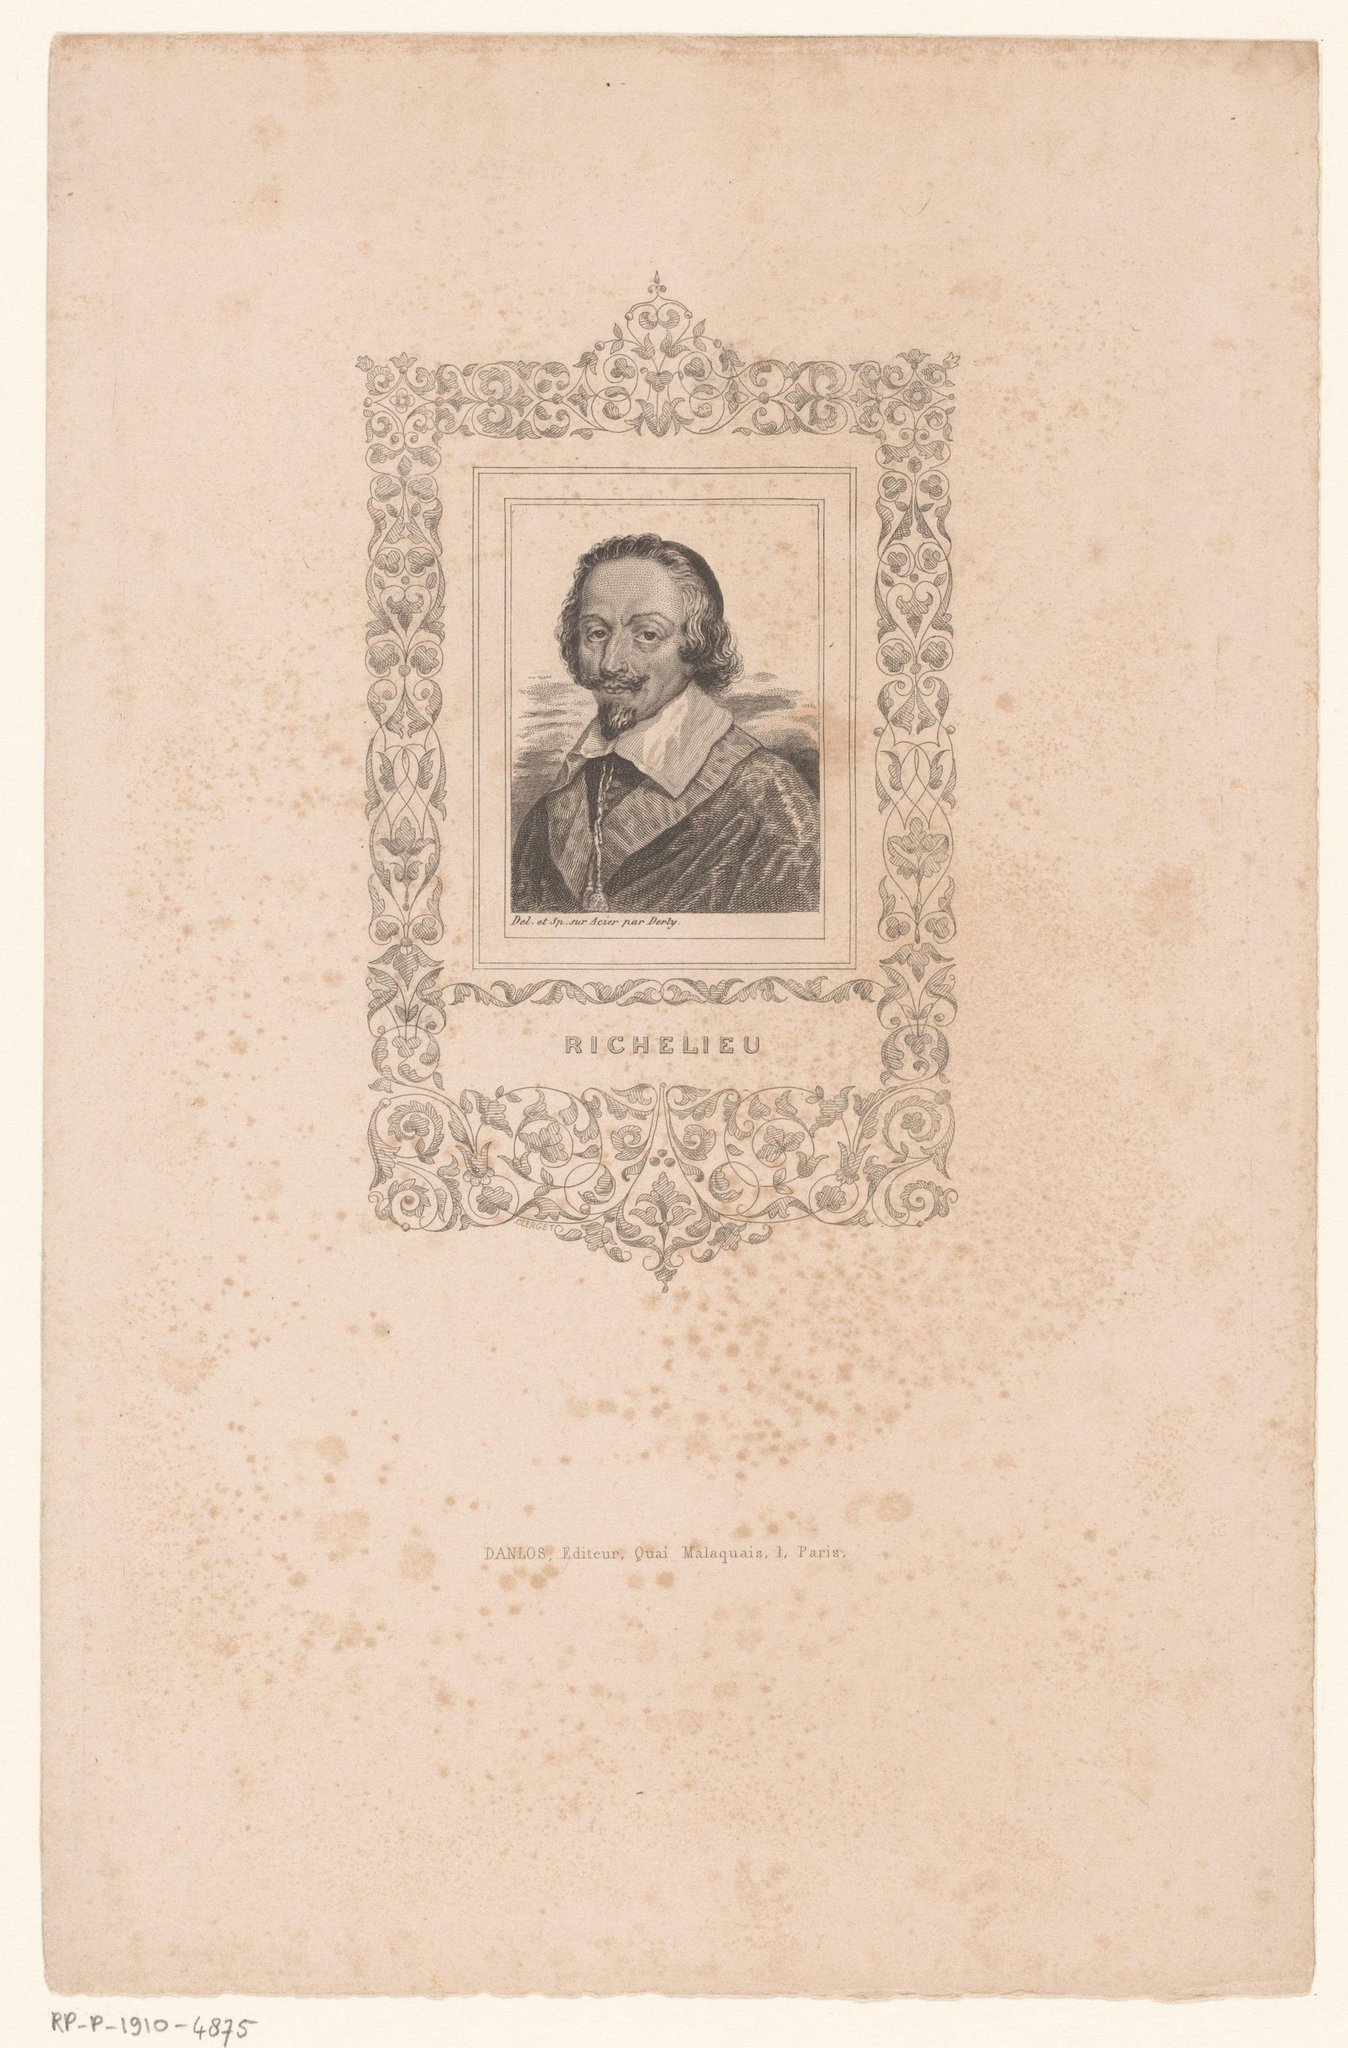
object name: print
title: Portret van Armand-Jean du Plessis hertog van Richelieu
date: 1820-1830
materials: paper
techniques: engraving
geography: paris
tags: paris, armand-jean du plessis hertog van richelieu, historical persons, organization, functionaries and dignitaries in roman catholic church; clergy in general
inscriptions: collector's mark: Lugt 2228